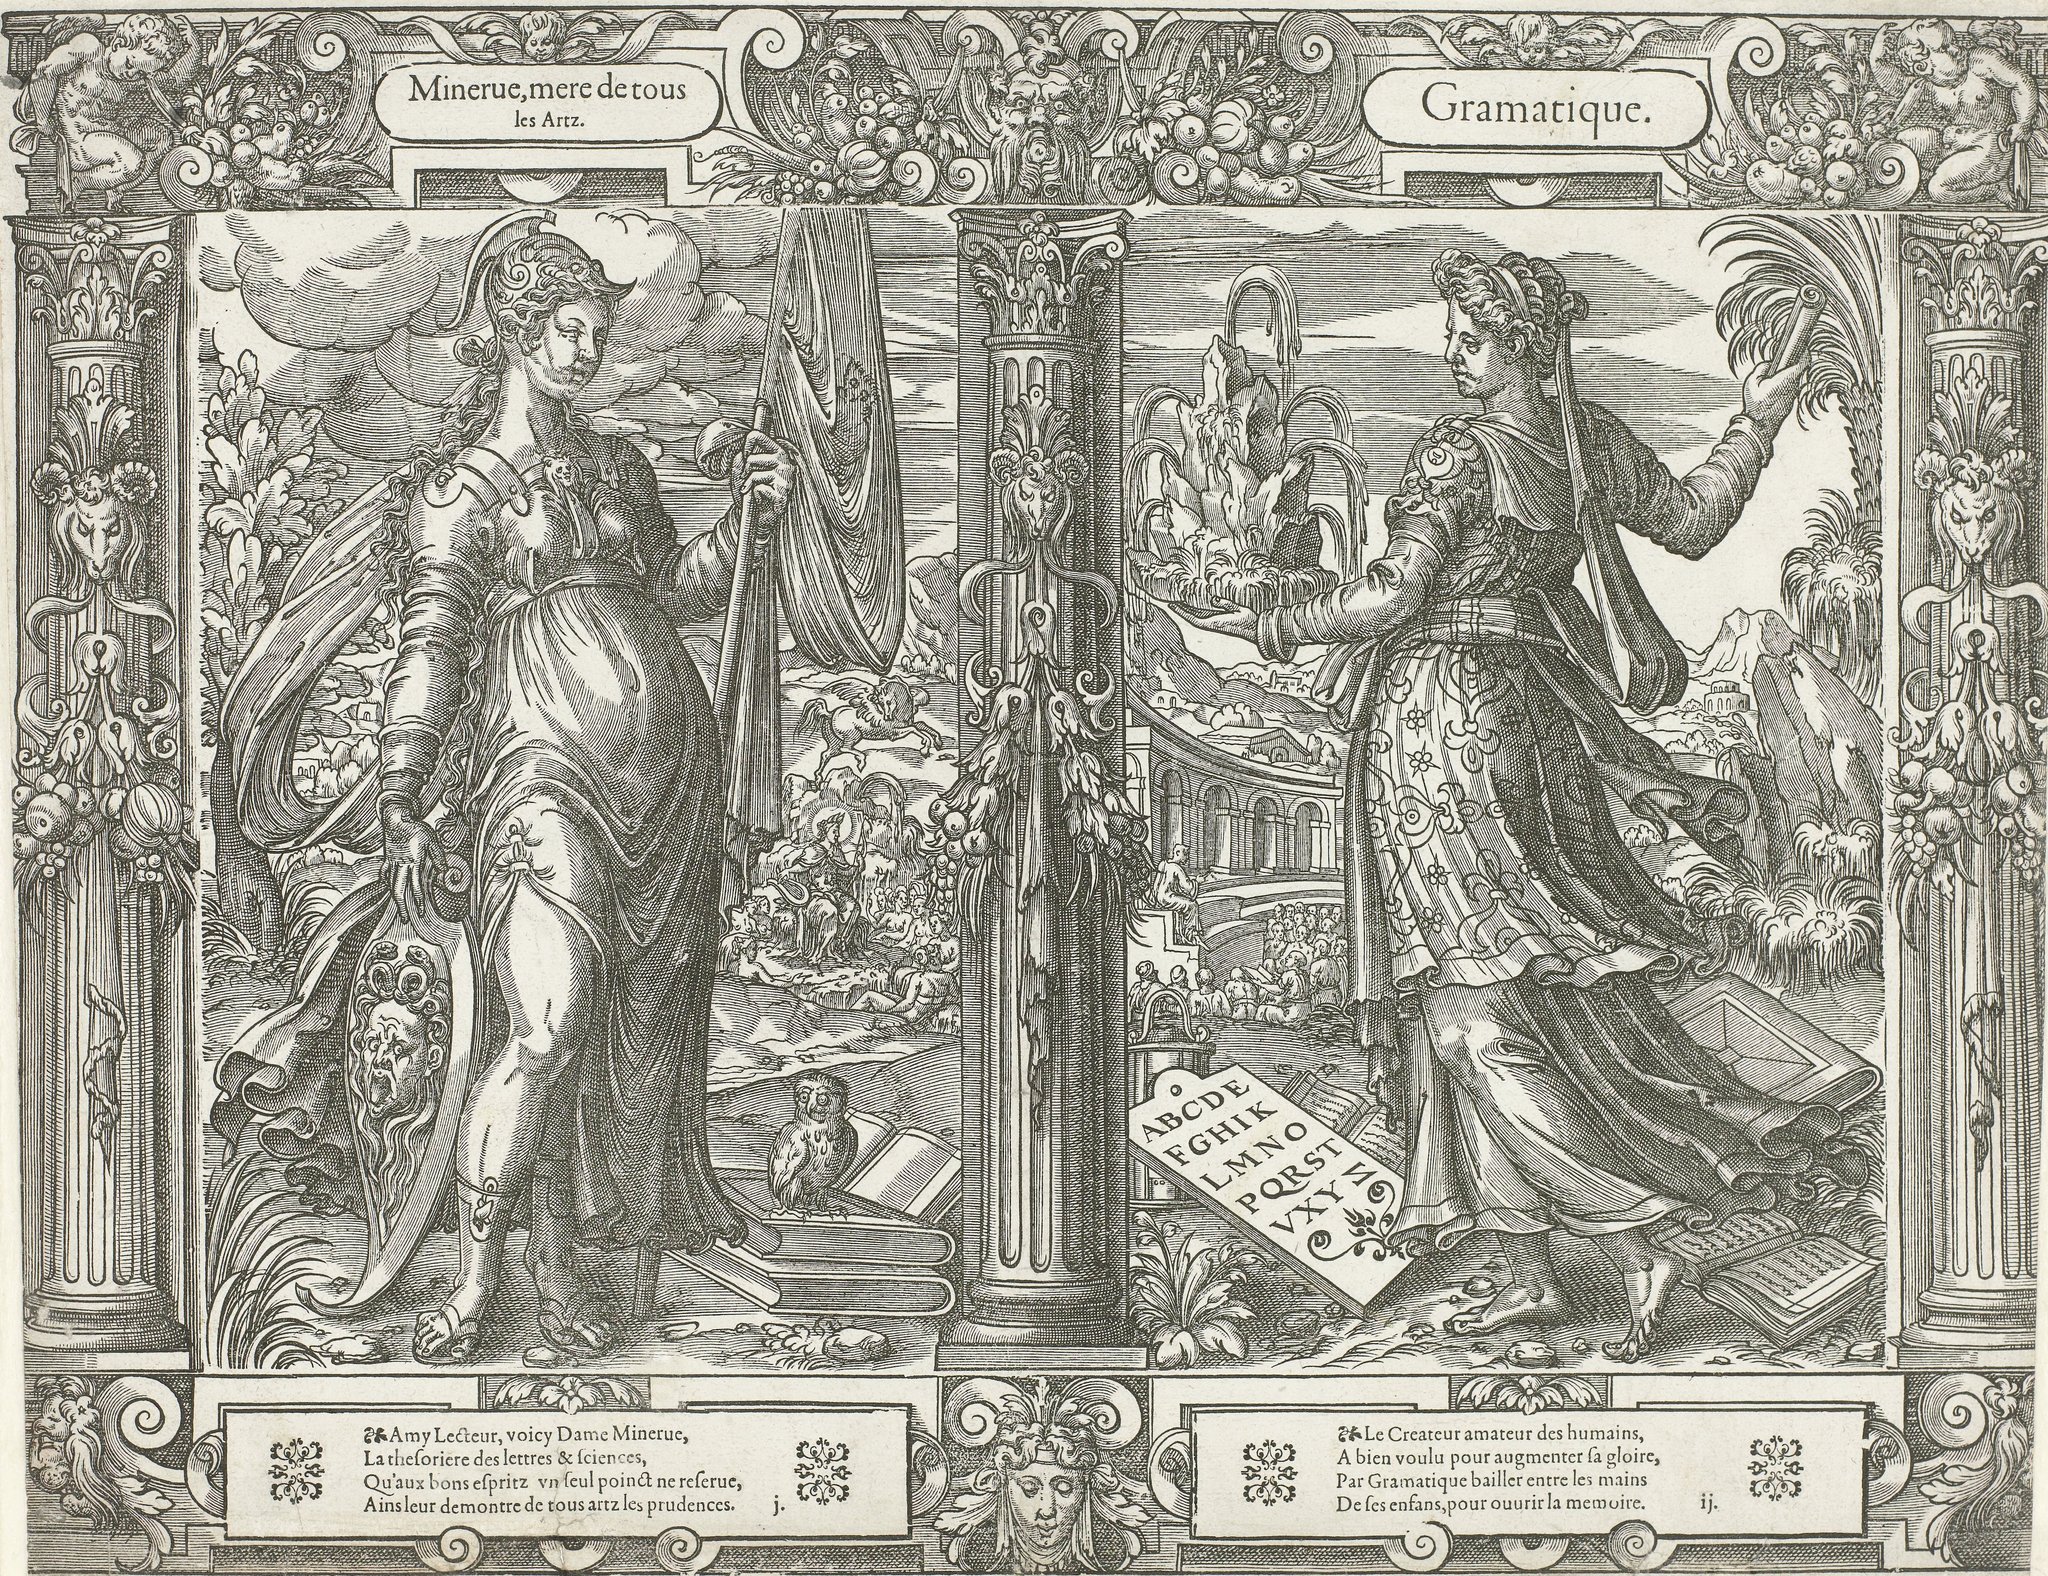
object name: print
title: Minerve, mere de tous les Artz. Gramatique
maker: marin bonnemer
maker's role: print maker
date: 1563-1573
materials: paper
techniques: woodcut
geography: paris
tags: (story of) minerva (pallas, athena), 'grammatica' (~ trivium); 'grammatica' (ripa)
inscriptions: collector's mark: Lugt 240, collector's mark: Lugt 2228